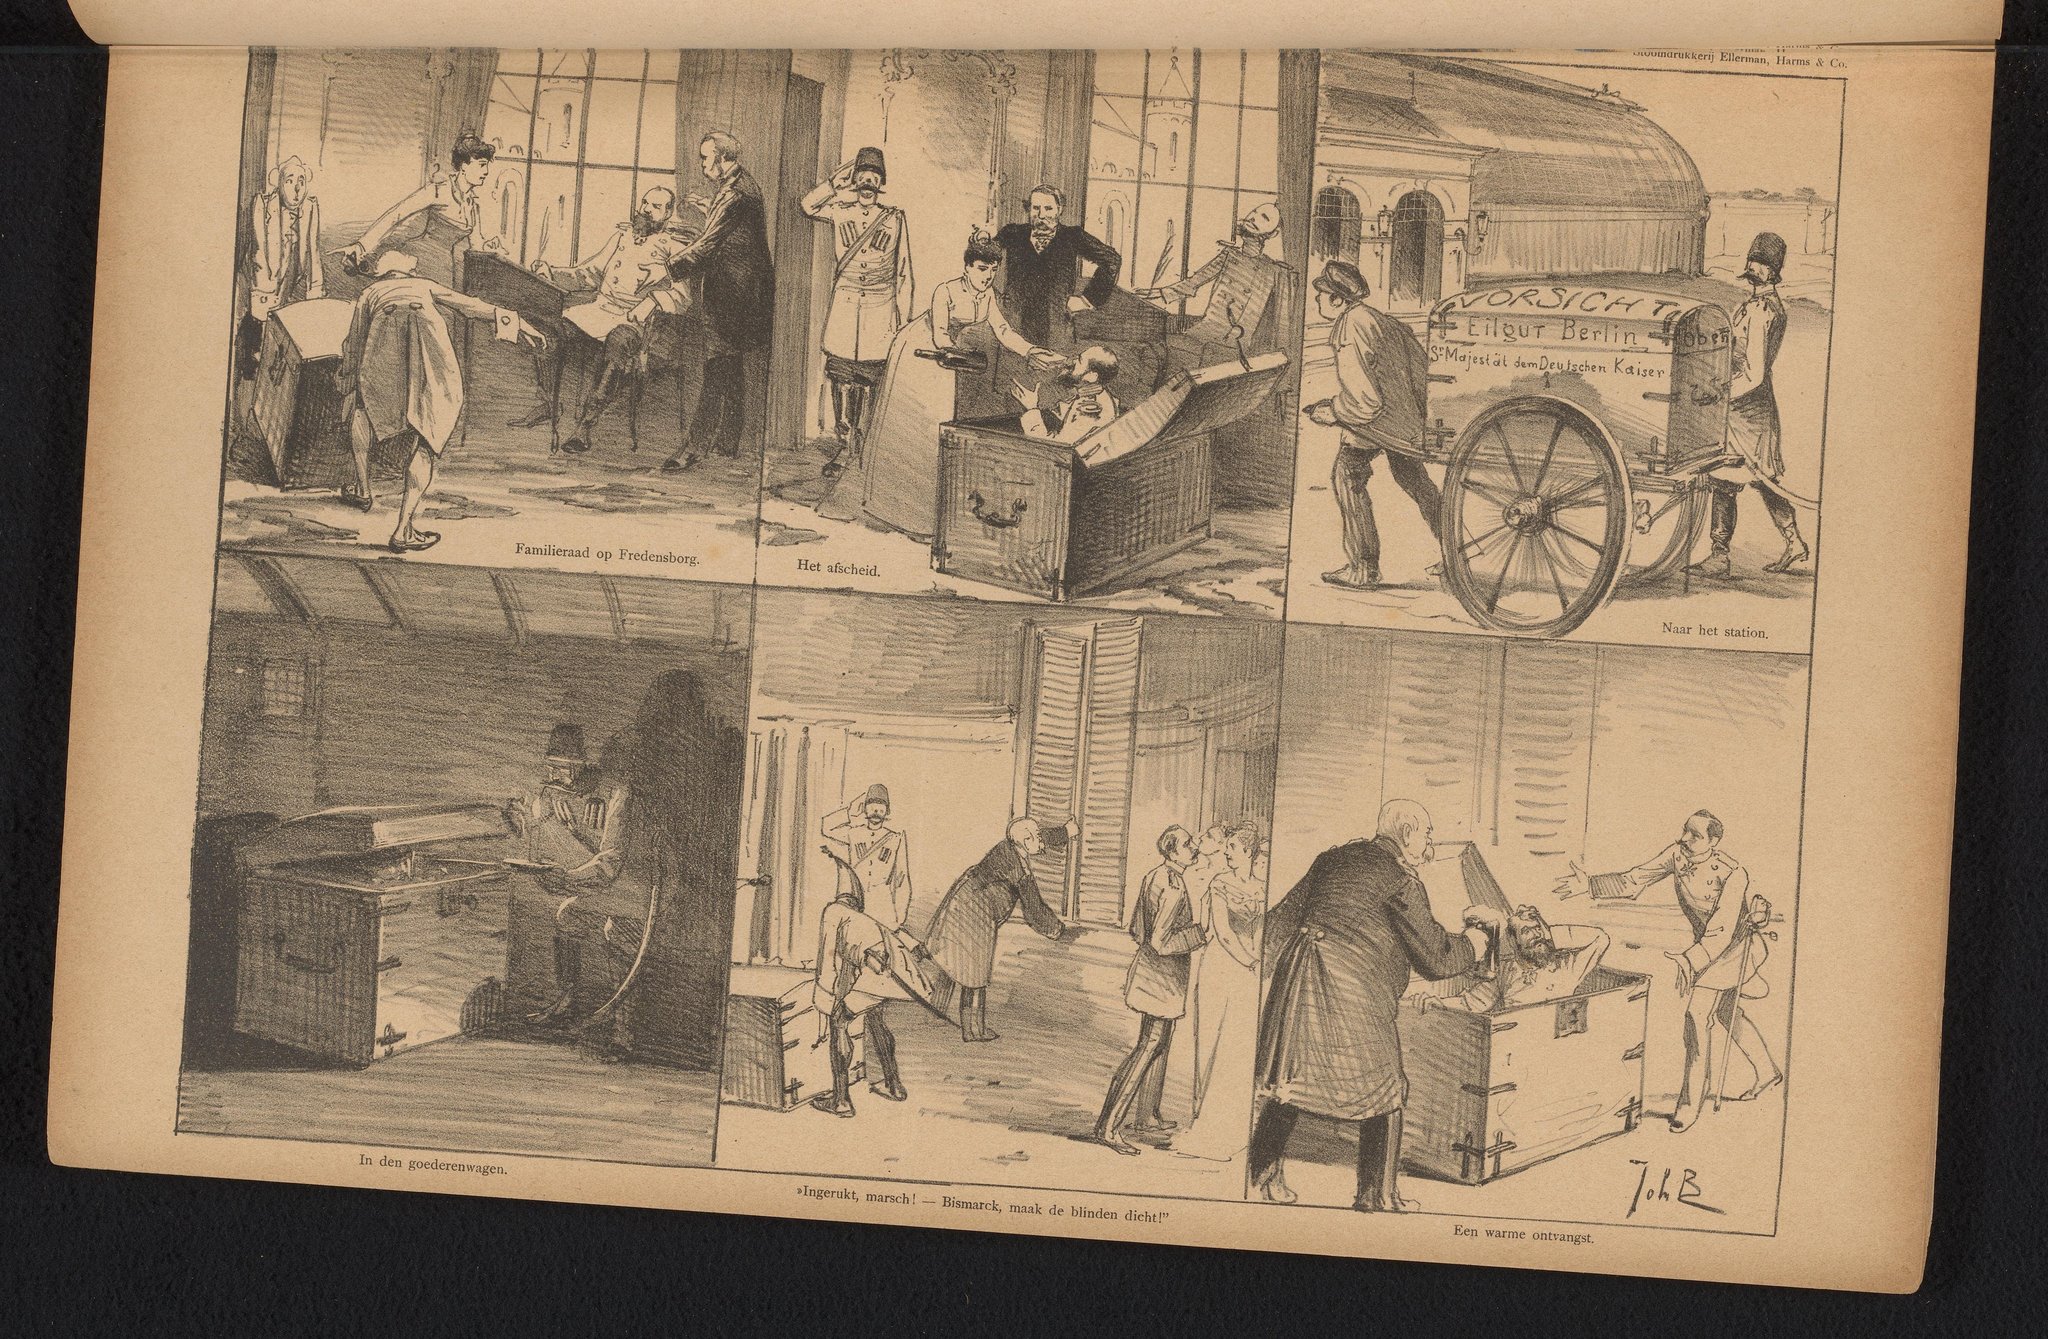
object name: cartoon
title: Strikt incognito, of de geheimzinnige reis van Kopenhagen naar Berlijn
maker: johan braakensiek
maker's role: draughtsman, print maker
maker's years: 1858-1940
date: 1889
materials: paper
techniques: lithograph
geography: netherlands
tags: wilhelm ii (keizer van duitsland), stadia of travel, porter, bearer, trunk, suit-case, political caricatures and satires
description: Zes scènes van de reis van een vorst (mogelijk tsaar Alexander III) vanuit het Fredensborg-paleis in Kopenhagen in een kist of hutkoffer naar Berlijn waar hij wordt ontvangen door keizer Wilhelm II en kanselier Bismarck.